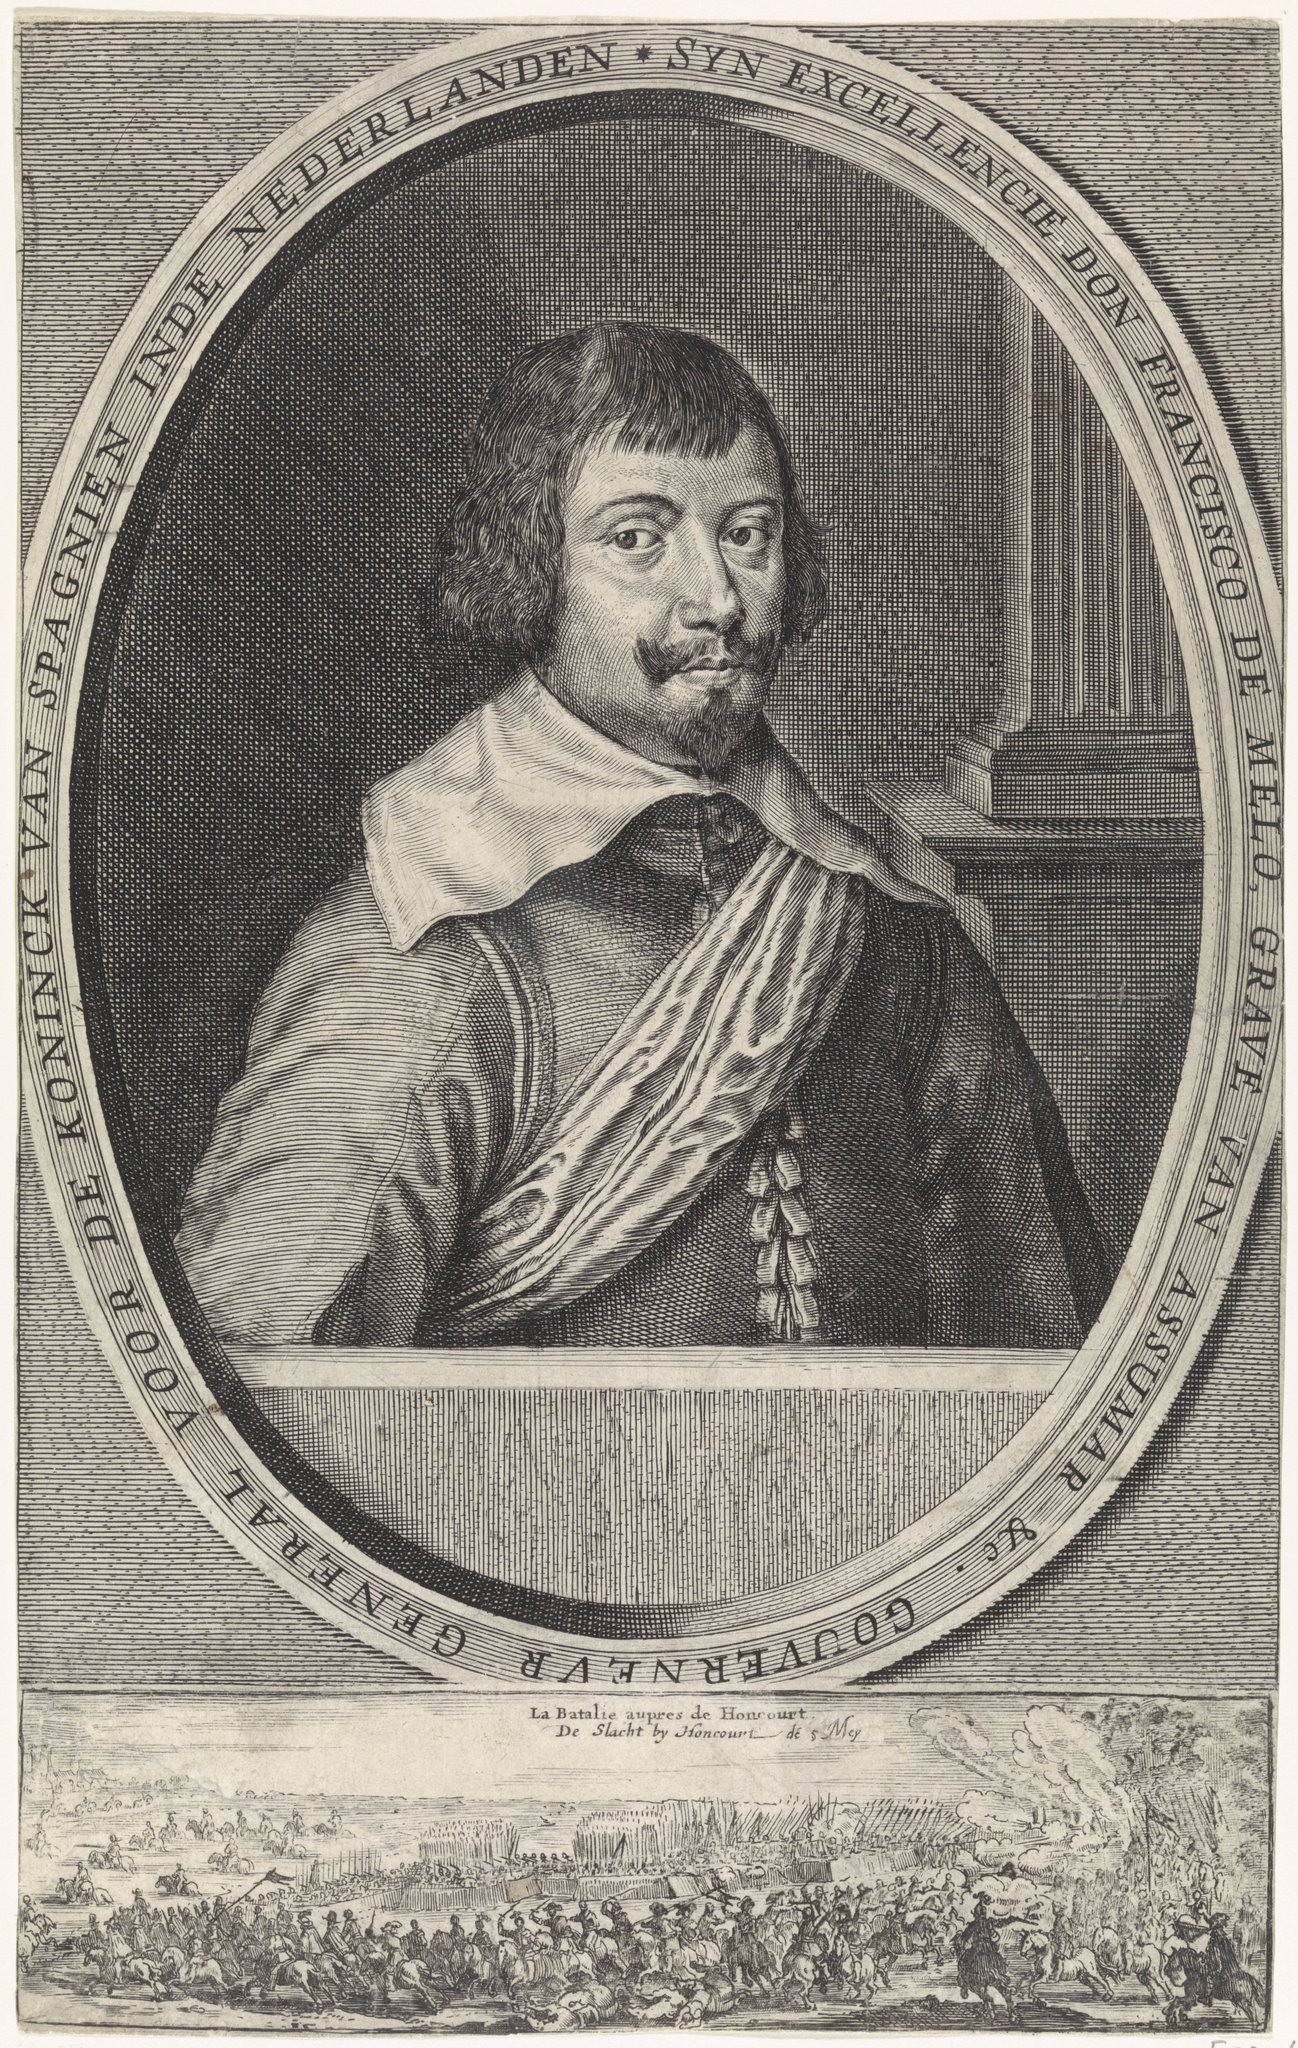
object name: print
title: Portret van Francisco de Melo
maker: crispijn van de passe (ii)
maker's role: draughtsman, print maker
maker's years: 1594-1670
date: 1604-1670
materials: paper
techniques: engraving, etching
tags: battle, fighting in general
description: Portret van Francisco de Melo, graaf van Assumar, en landvoogd van de Zuidelijke Nederlanden. In het randschrift van de omlijsting de naam en functie van de geportretteerde in het Nederlands. In de marge een voorstelling van de slag bij Honcourt op 5 mei.